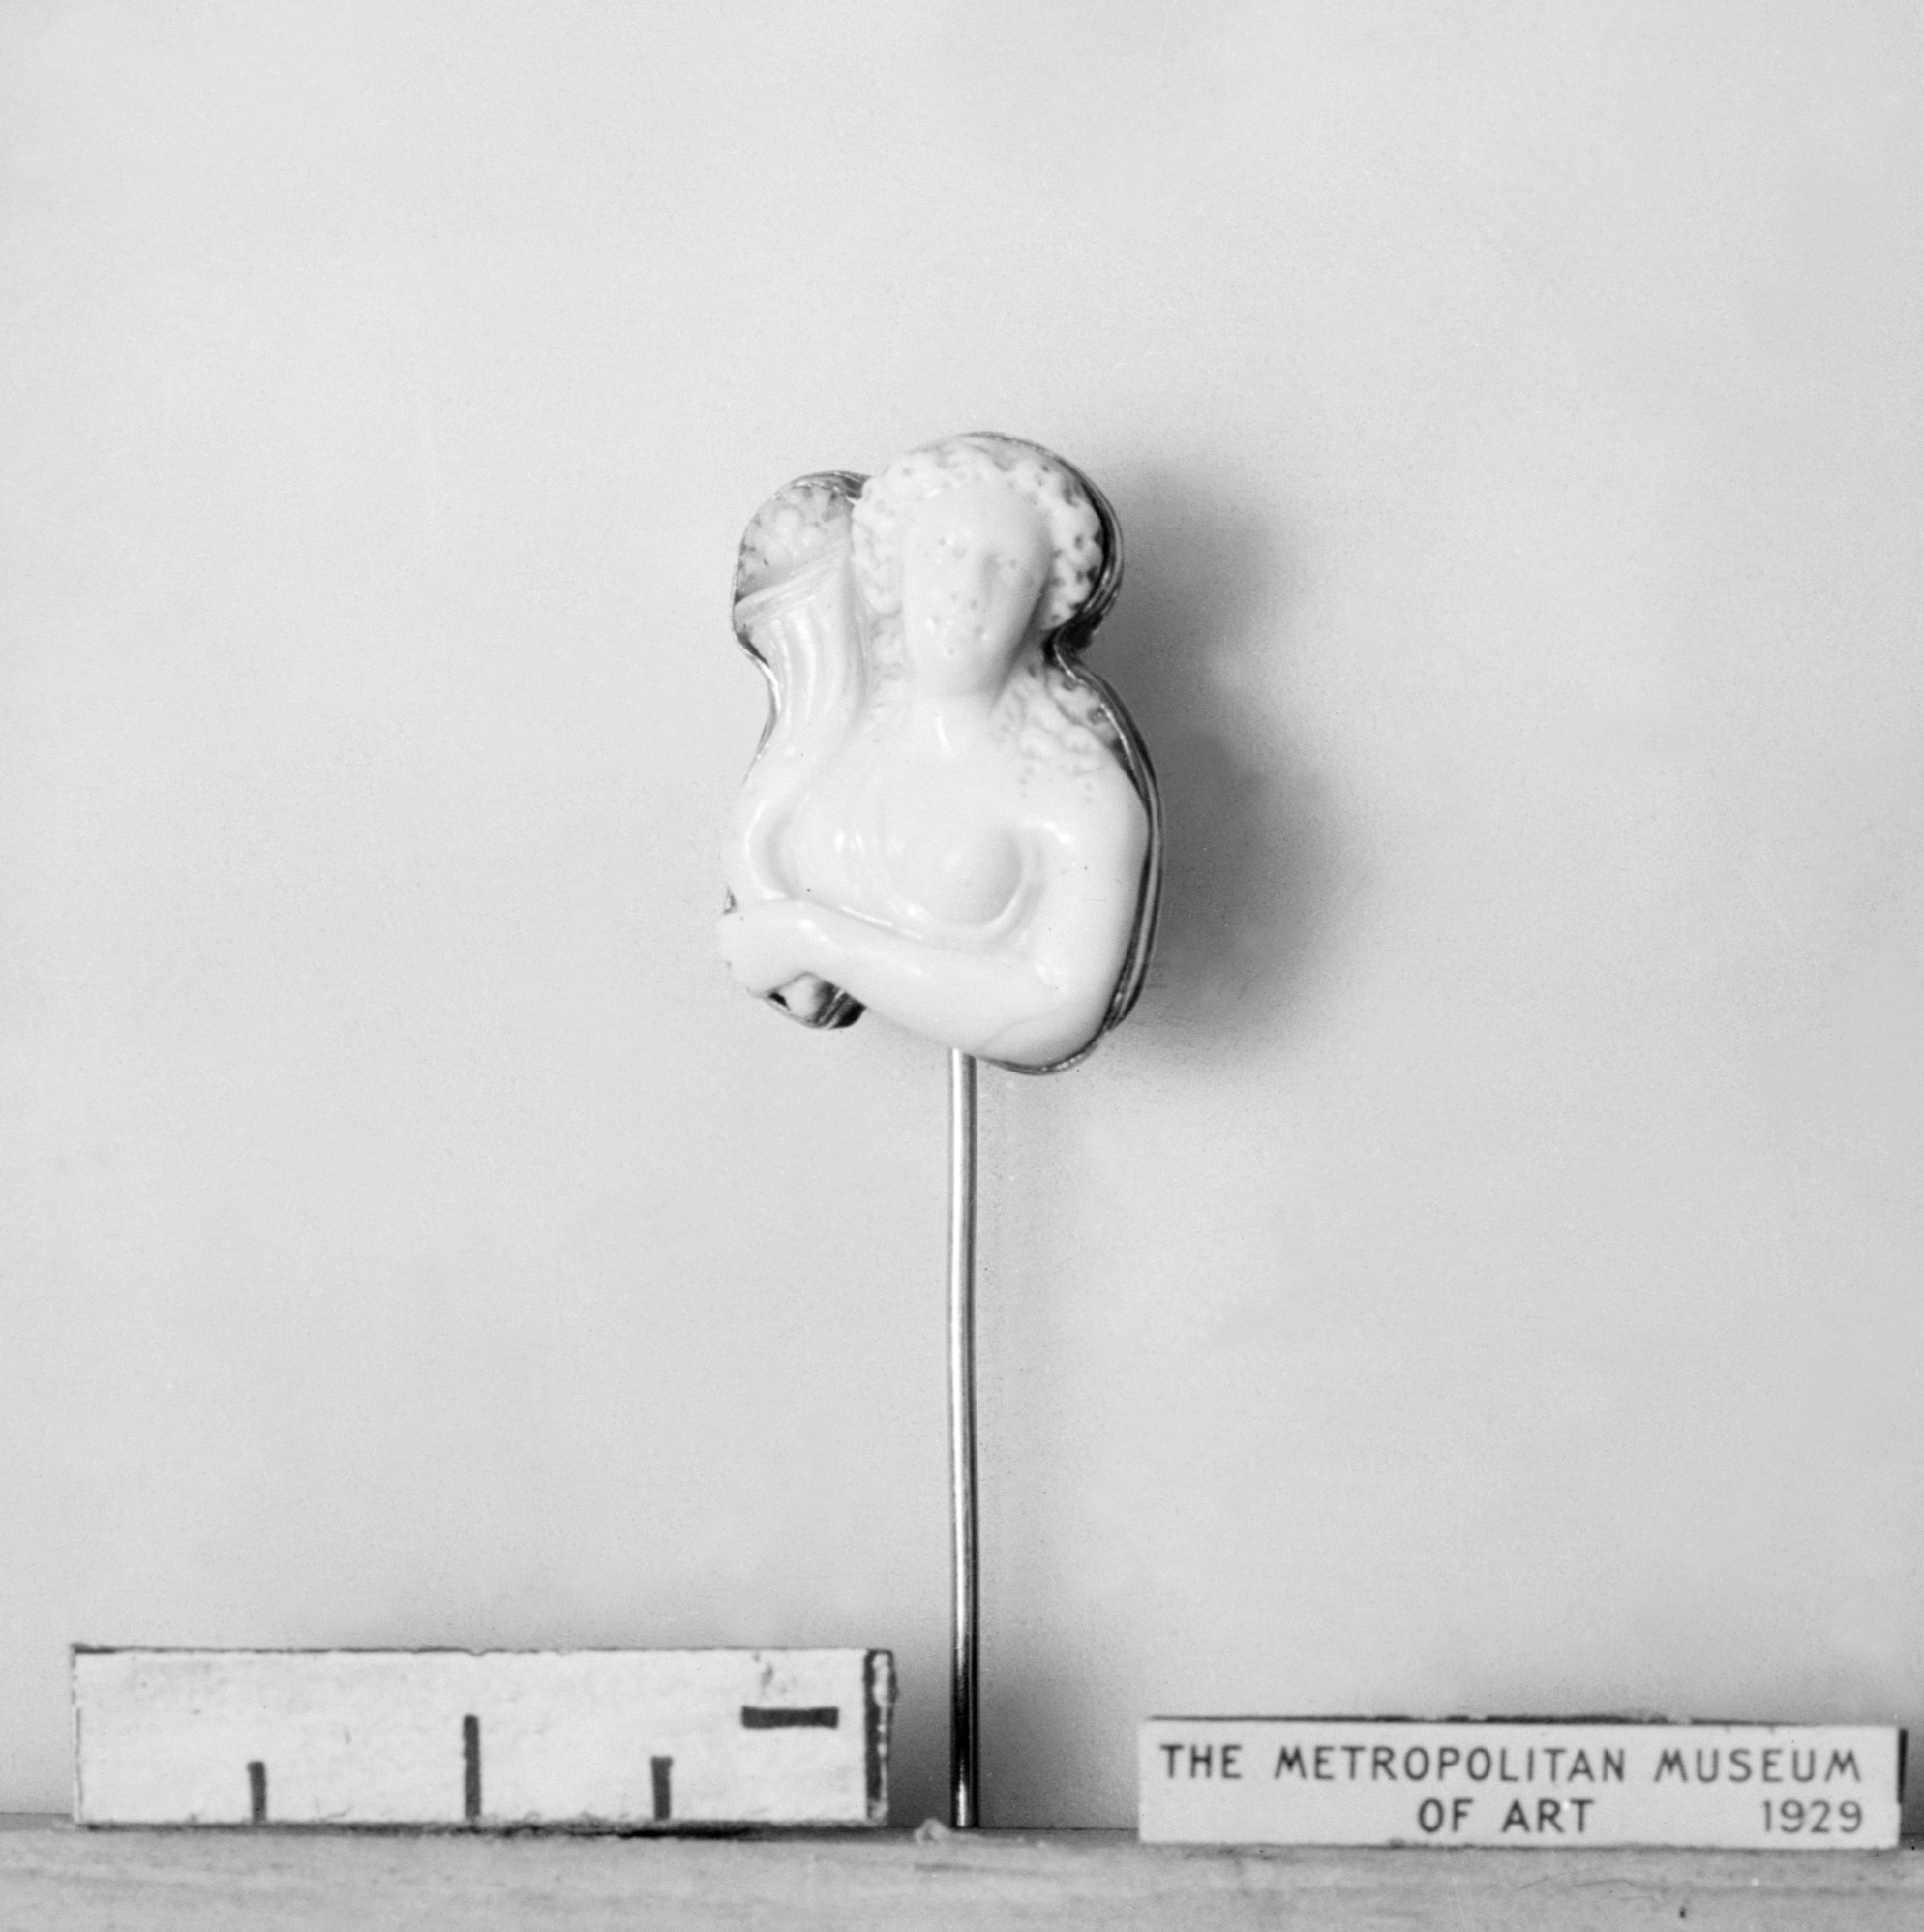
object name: cameo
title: Bust of Pomona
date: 1567-1600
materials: stone, gold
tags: portraits,female nudes